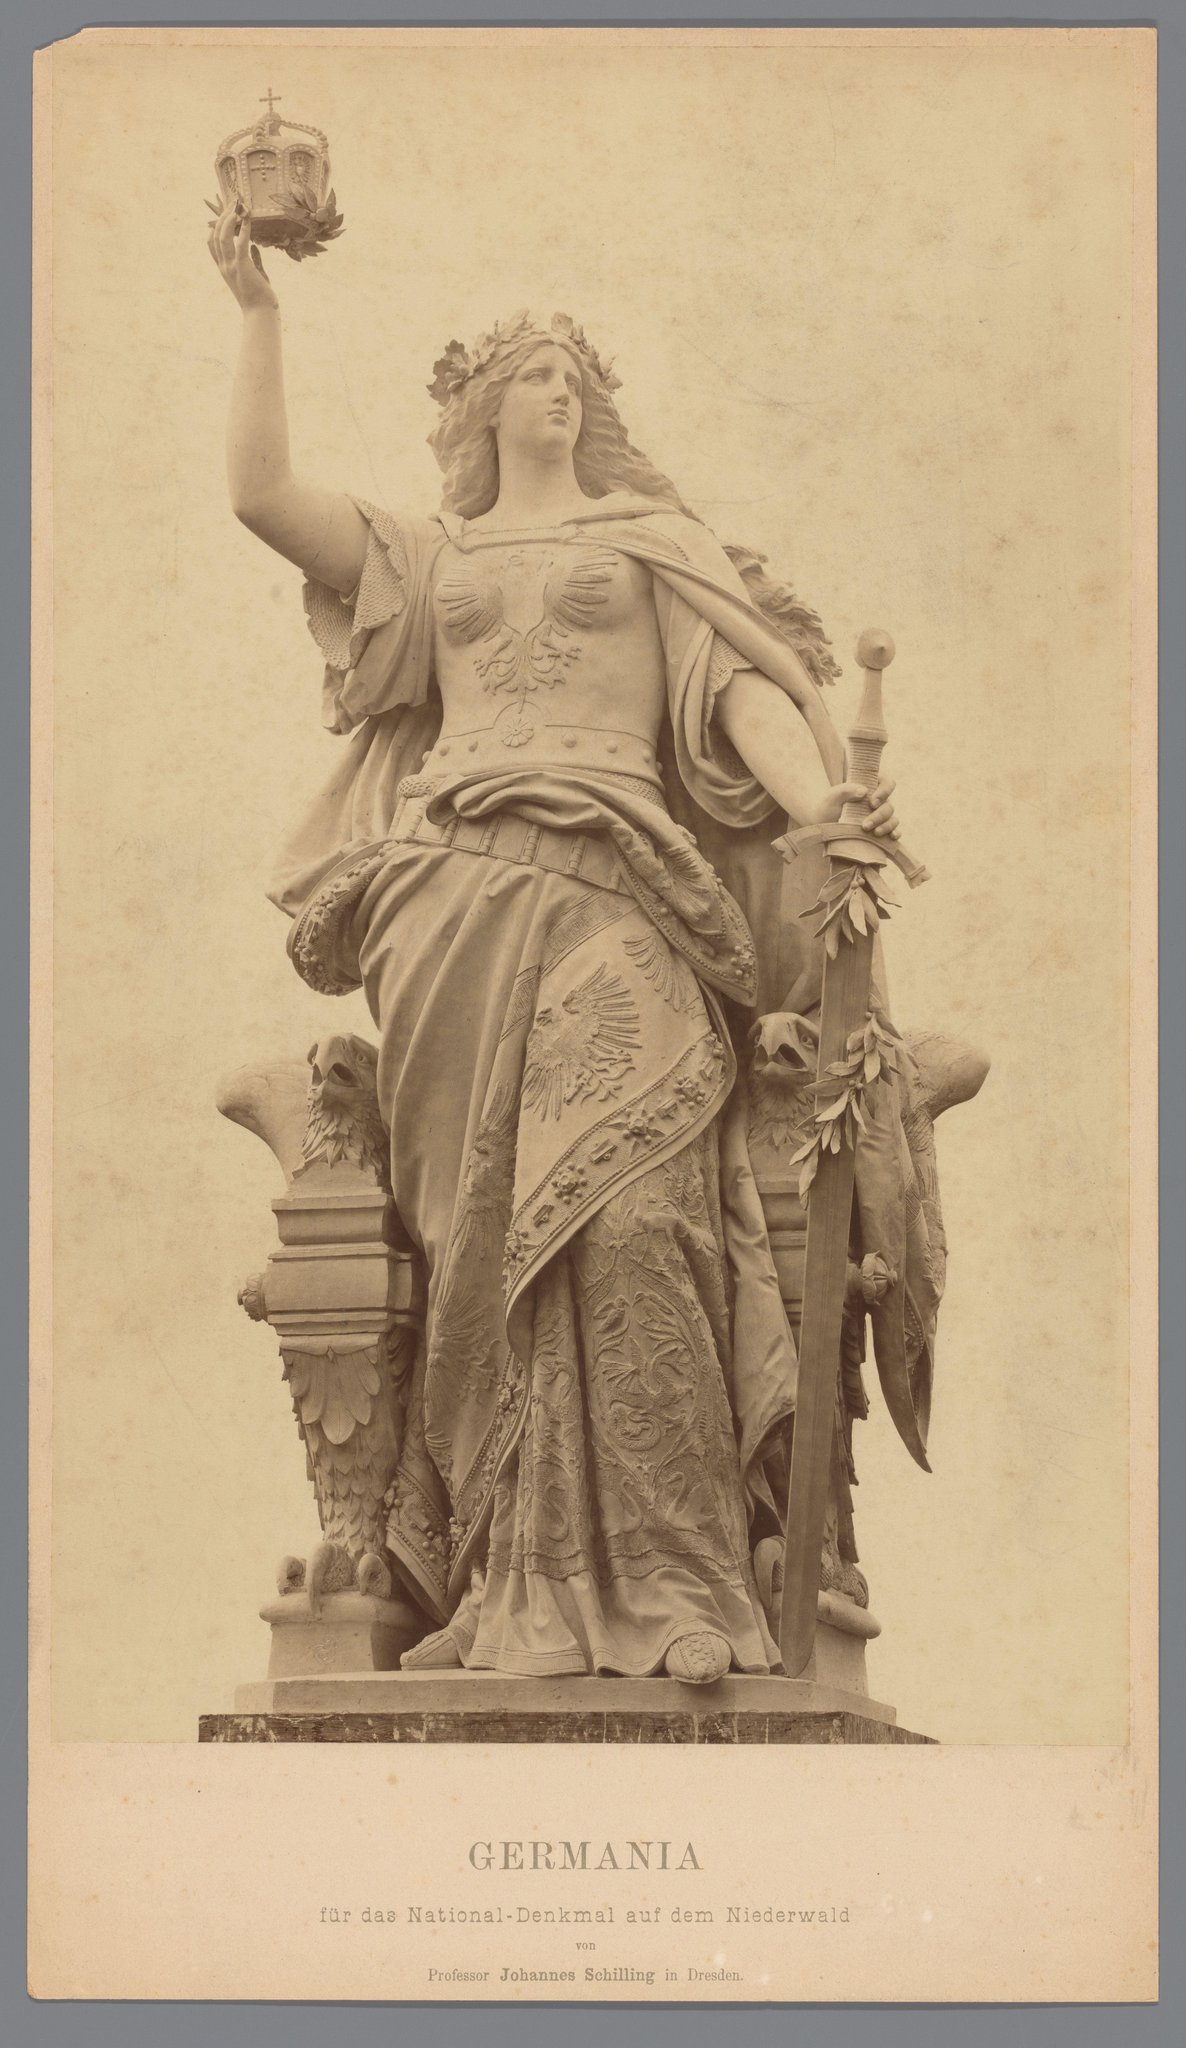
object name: photograph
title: Germania für das National-Denkmal auf dem Niederwald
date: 1887-1920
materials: paper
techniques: albumen print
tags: niederwald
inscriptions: number: ‘'16.4’